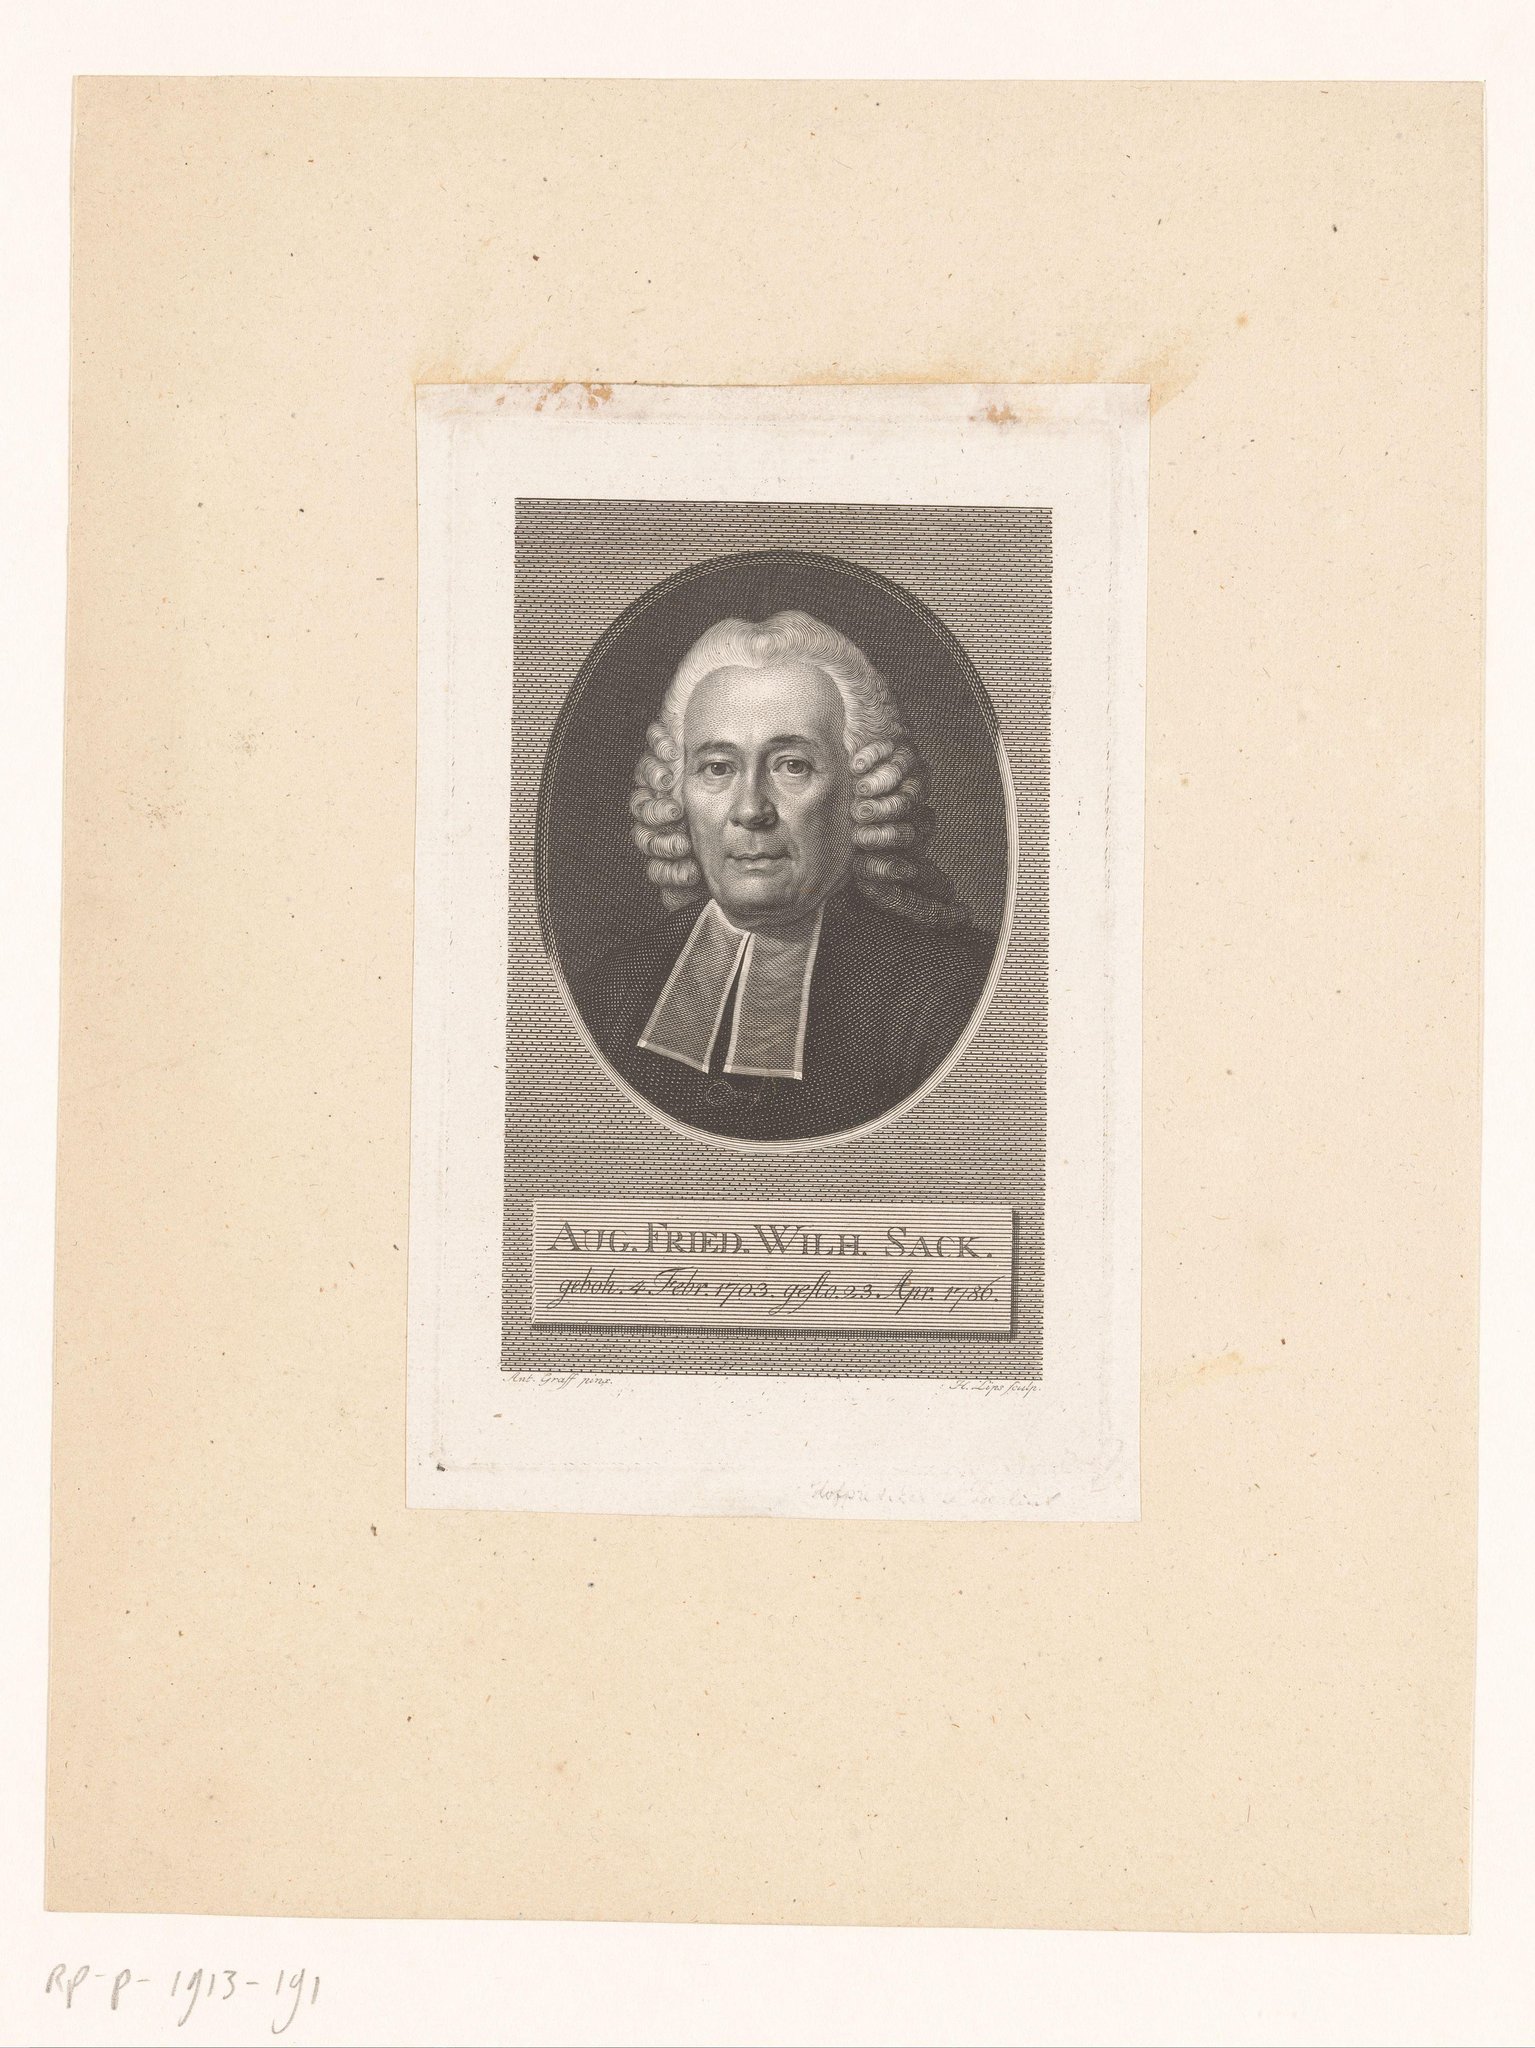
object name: print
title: Portret van August Friedrich Wilhelm Sack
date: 1768-1817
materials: paper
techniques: engraving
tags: berlin, theologian, historical persons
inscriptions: collector's mark: Lugt 2228